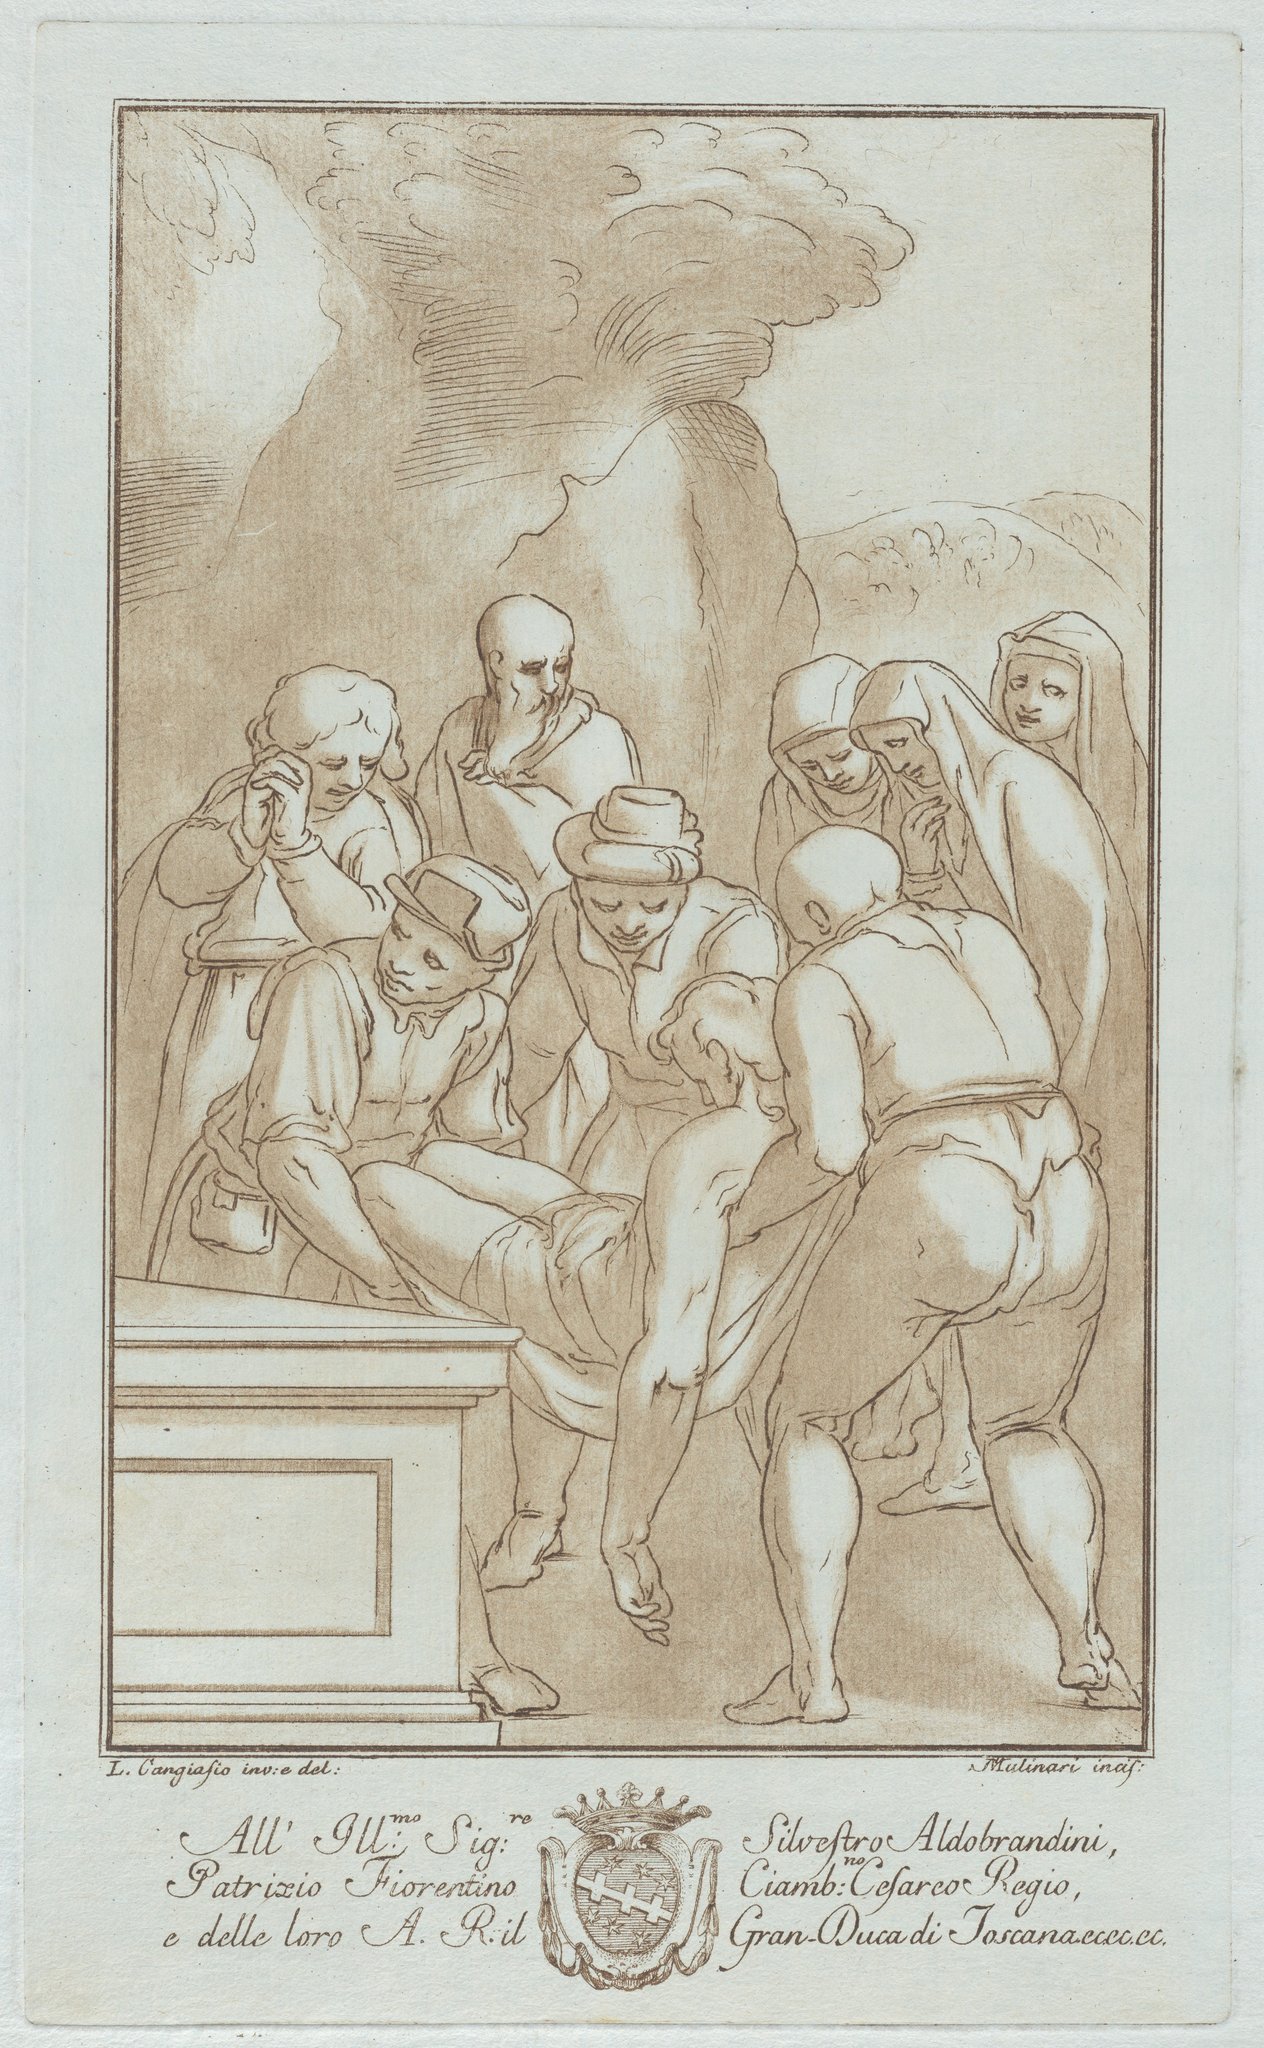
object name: print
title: The Entombment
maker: stefano mulinari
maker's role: artist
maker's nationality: italian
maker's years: 1736-1795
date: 1780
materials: paper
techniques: etching, wash